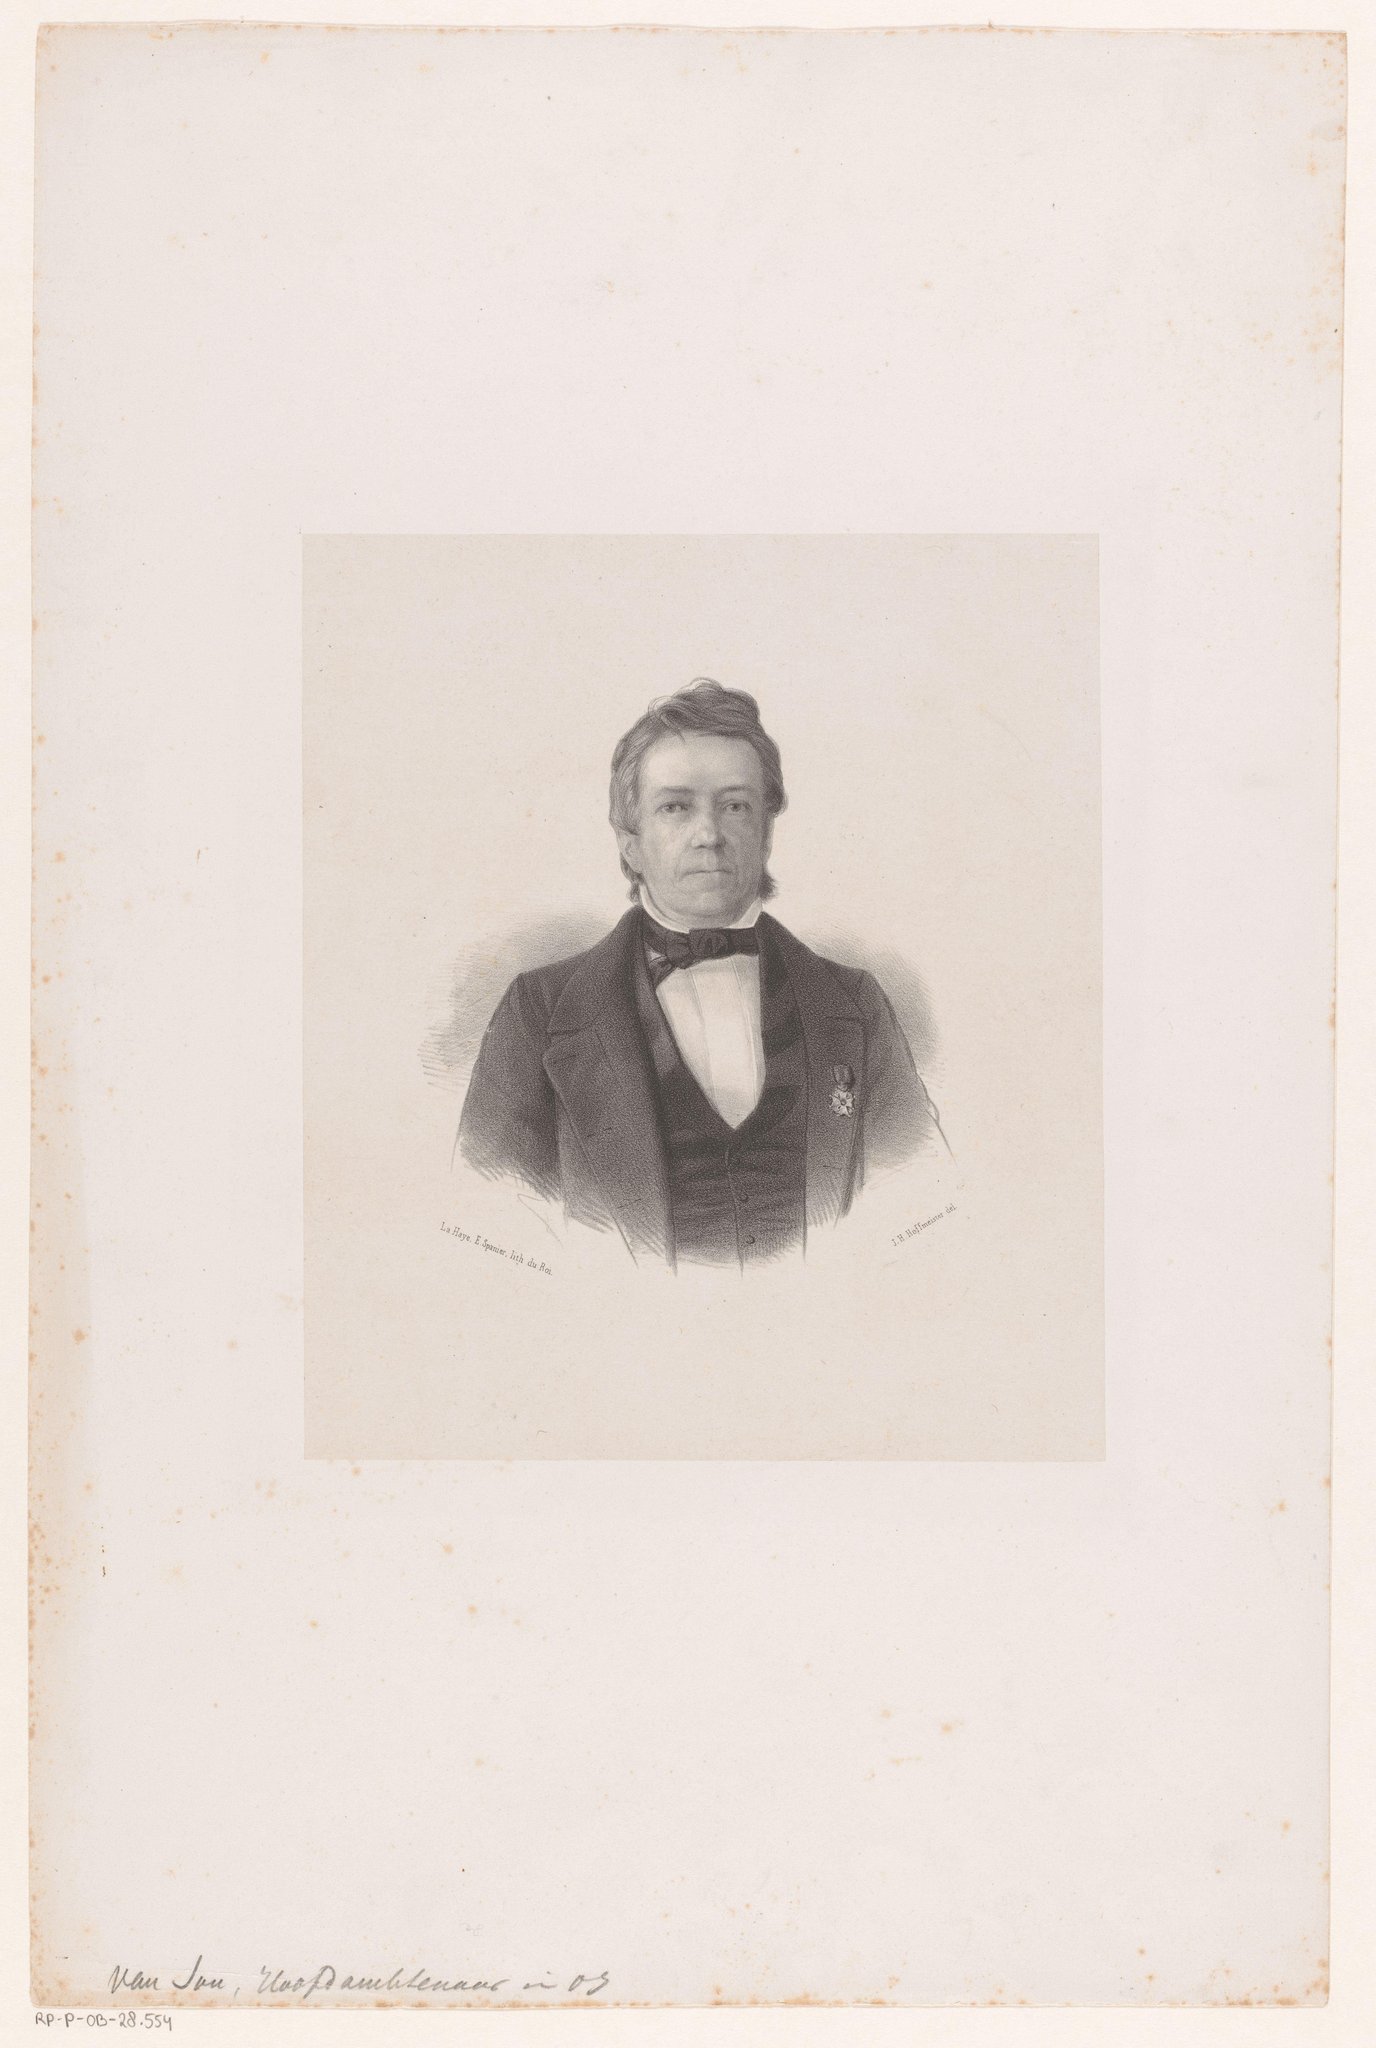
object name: print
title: Portret van een onbekende man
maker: johan hendrik hoffmeister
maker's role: print maker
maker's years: 1823-1904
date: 1851-1883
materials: paper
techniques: lithograph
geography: the hague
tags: historical persons (+ (full) bust portrait)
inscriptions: collector's mark: Lugt 2228, inscription: ‘Van Son, Doopambtenaar in Os’